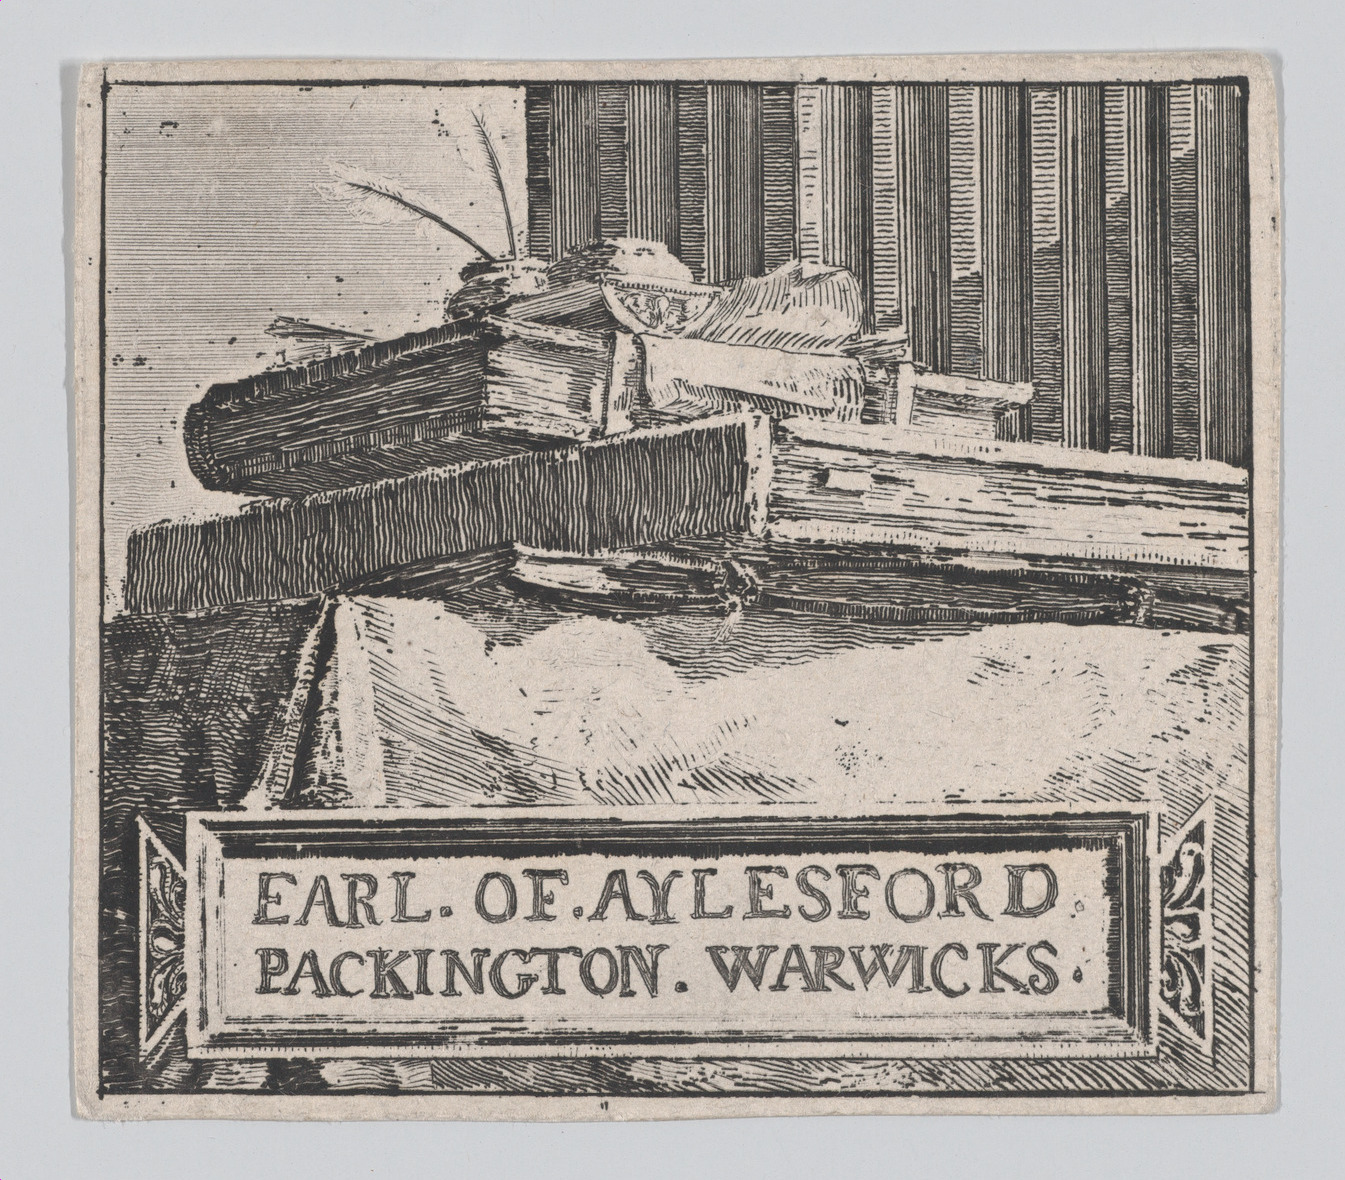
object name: print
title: Third Bookplate of the Earl of Aylesford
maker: heneage finch, 4th earl of aylesford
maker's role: artist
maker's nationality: british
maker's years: 1751-1812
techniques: etching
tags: books